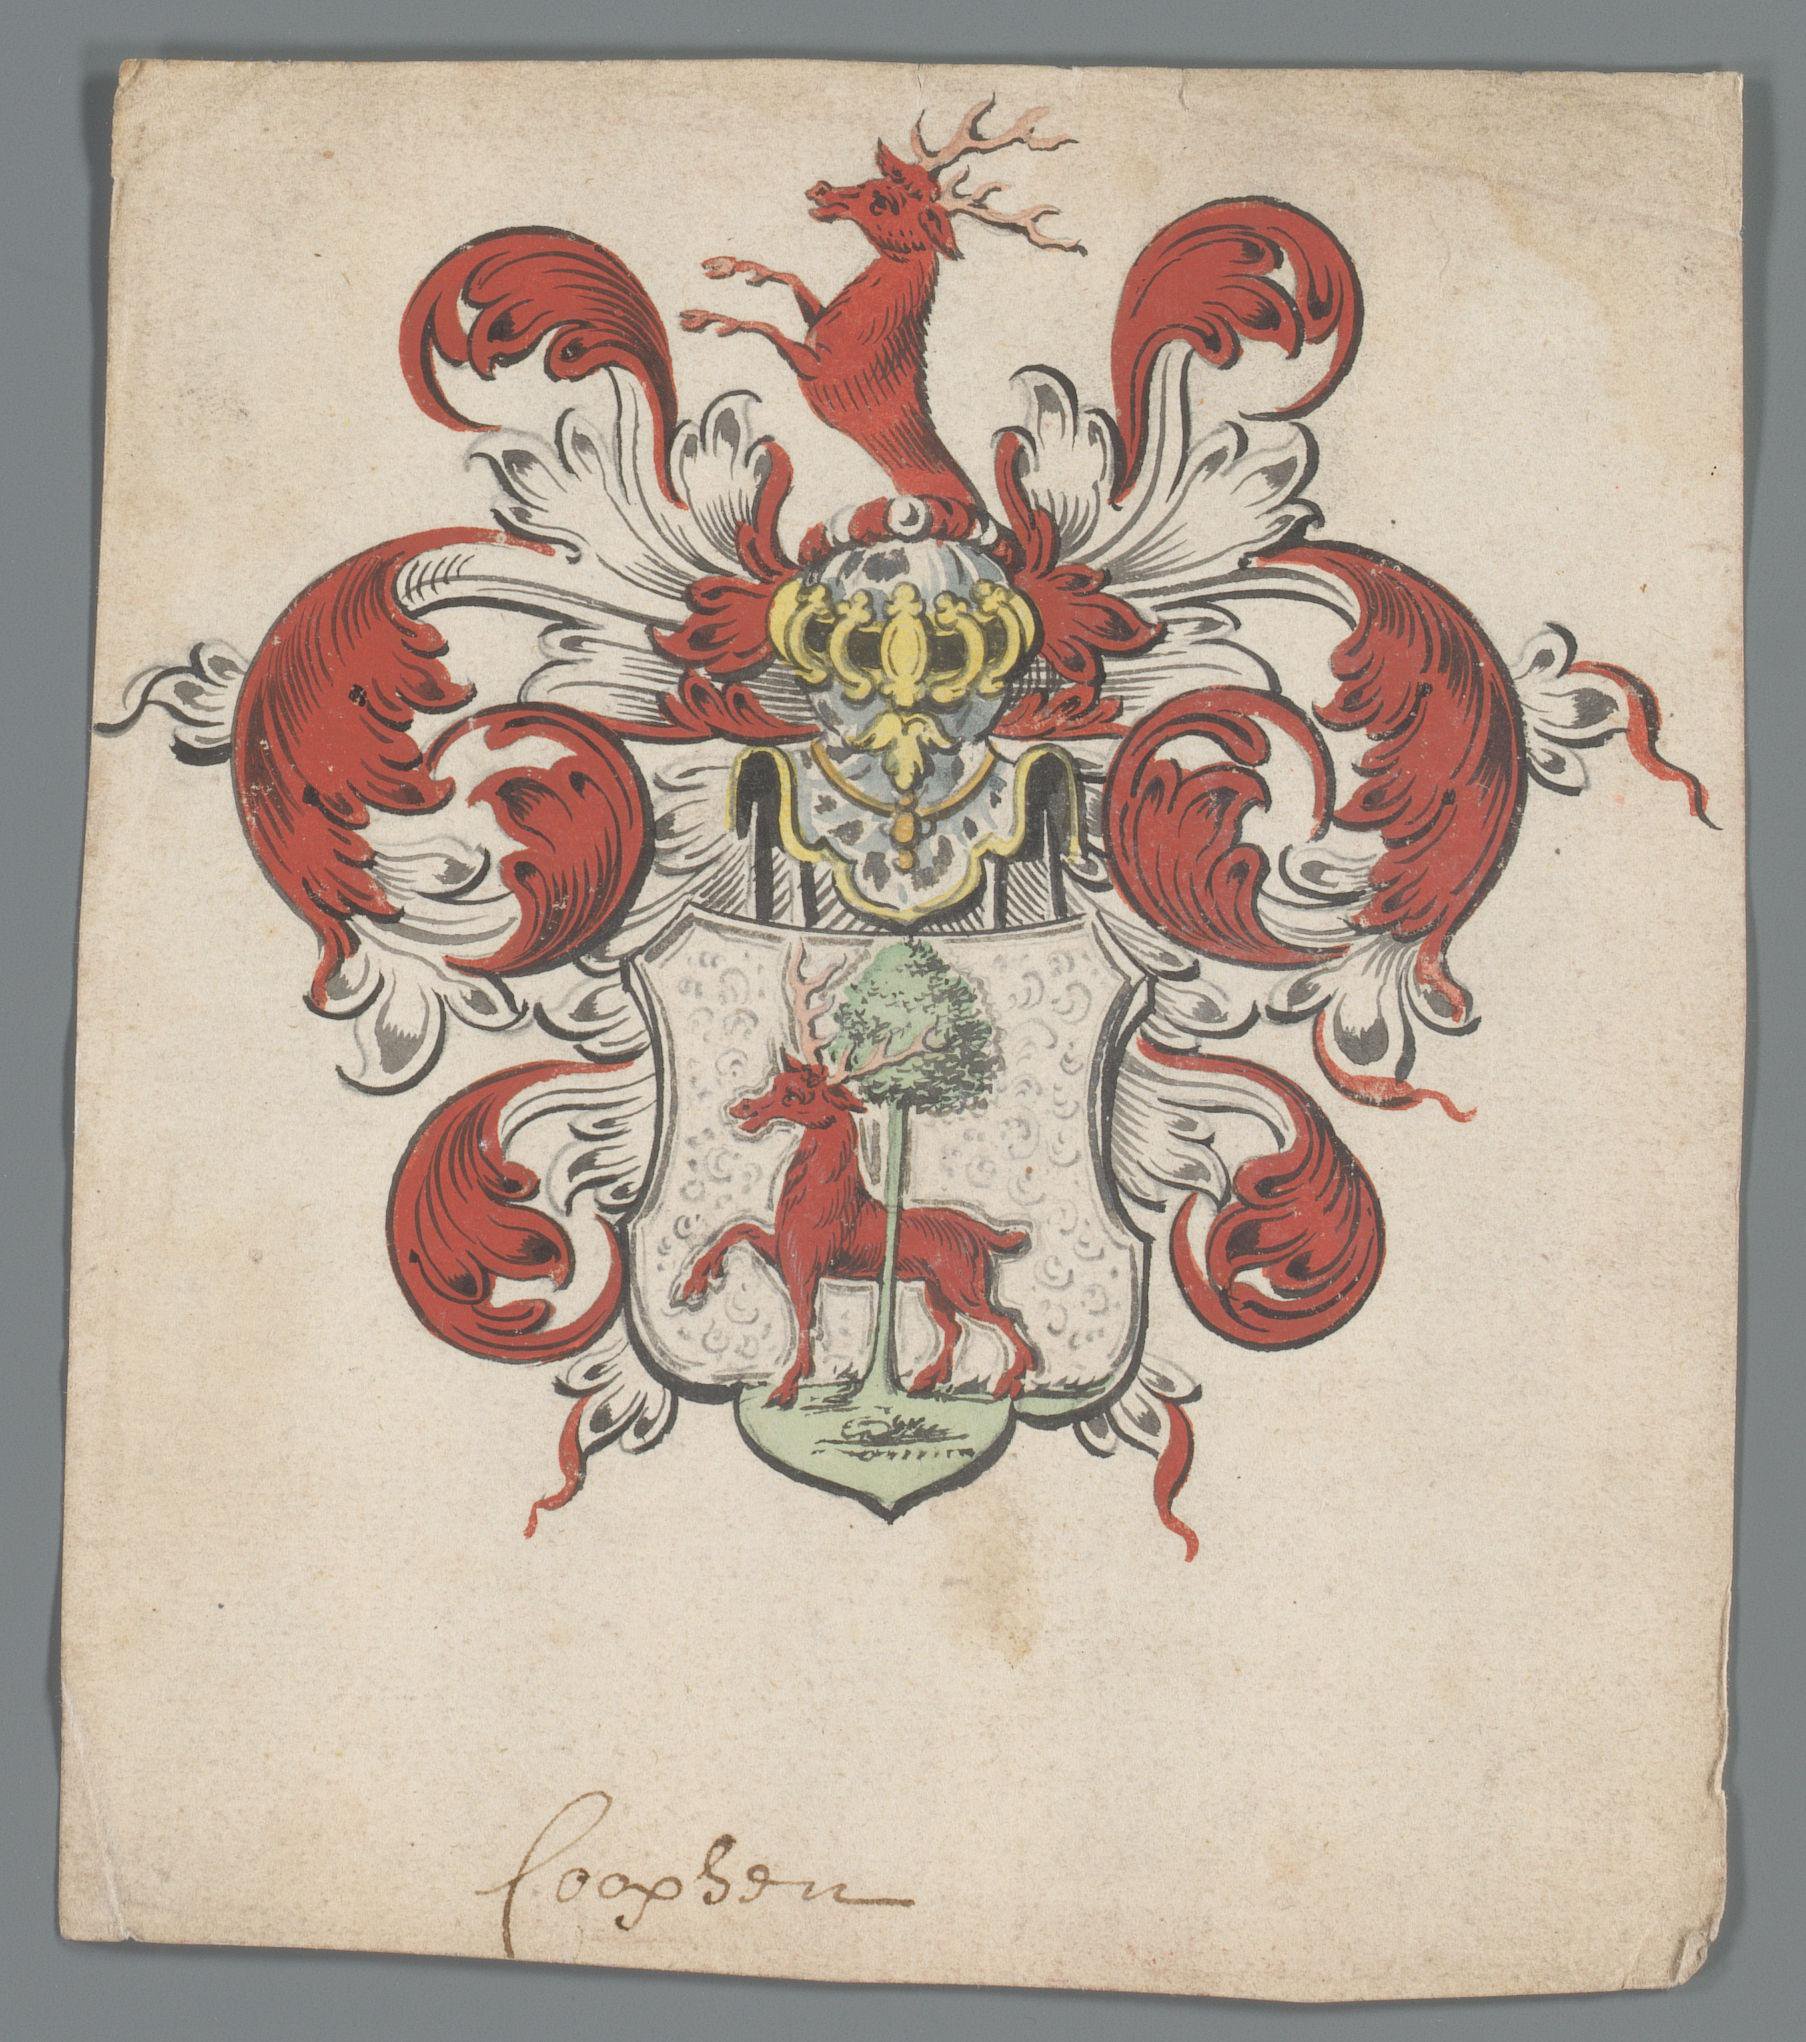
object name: drawing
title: Wapenschild van het geslacht Coophen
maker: Anonymous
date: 1600-1699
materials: paper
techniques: brush, pen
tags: helmet, hoofed animals: deer, armorial bearing, heraldry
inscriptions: inscription: ‘Coophen’